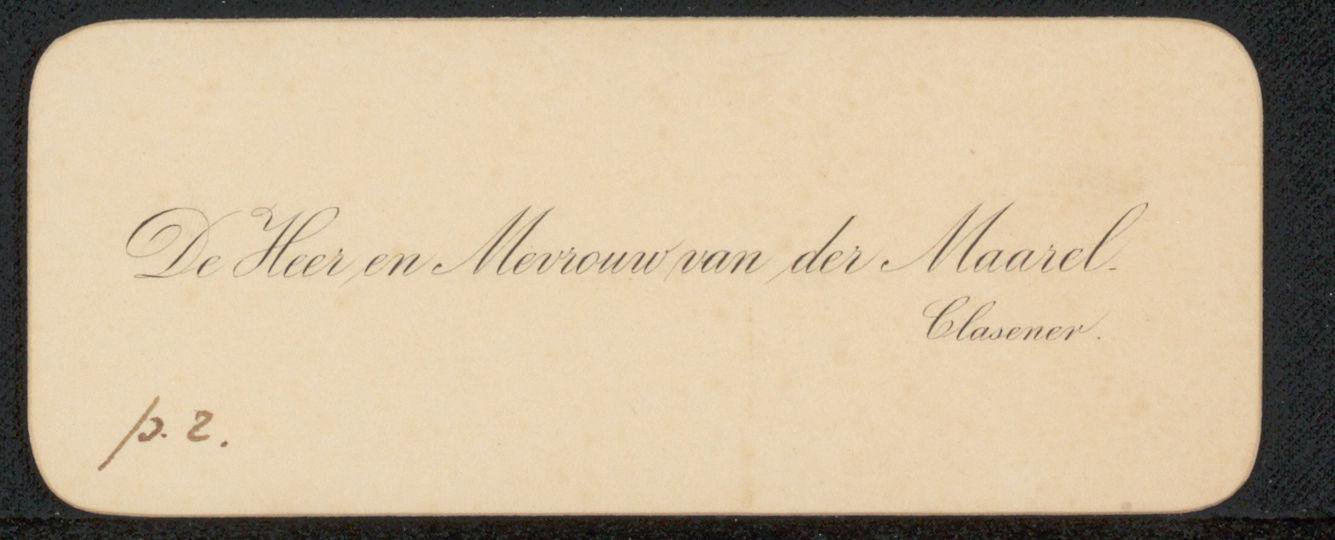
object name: visiting card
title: Visitekaartje aan Philip Zilcken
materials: cardboard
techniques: printing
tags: philip zilcken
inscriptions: collector's mark: ‘RPK’